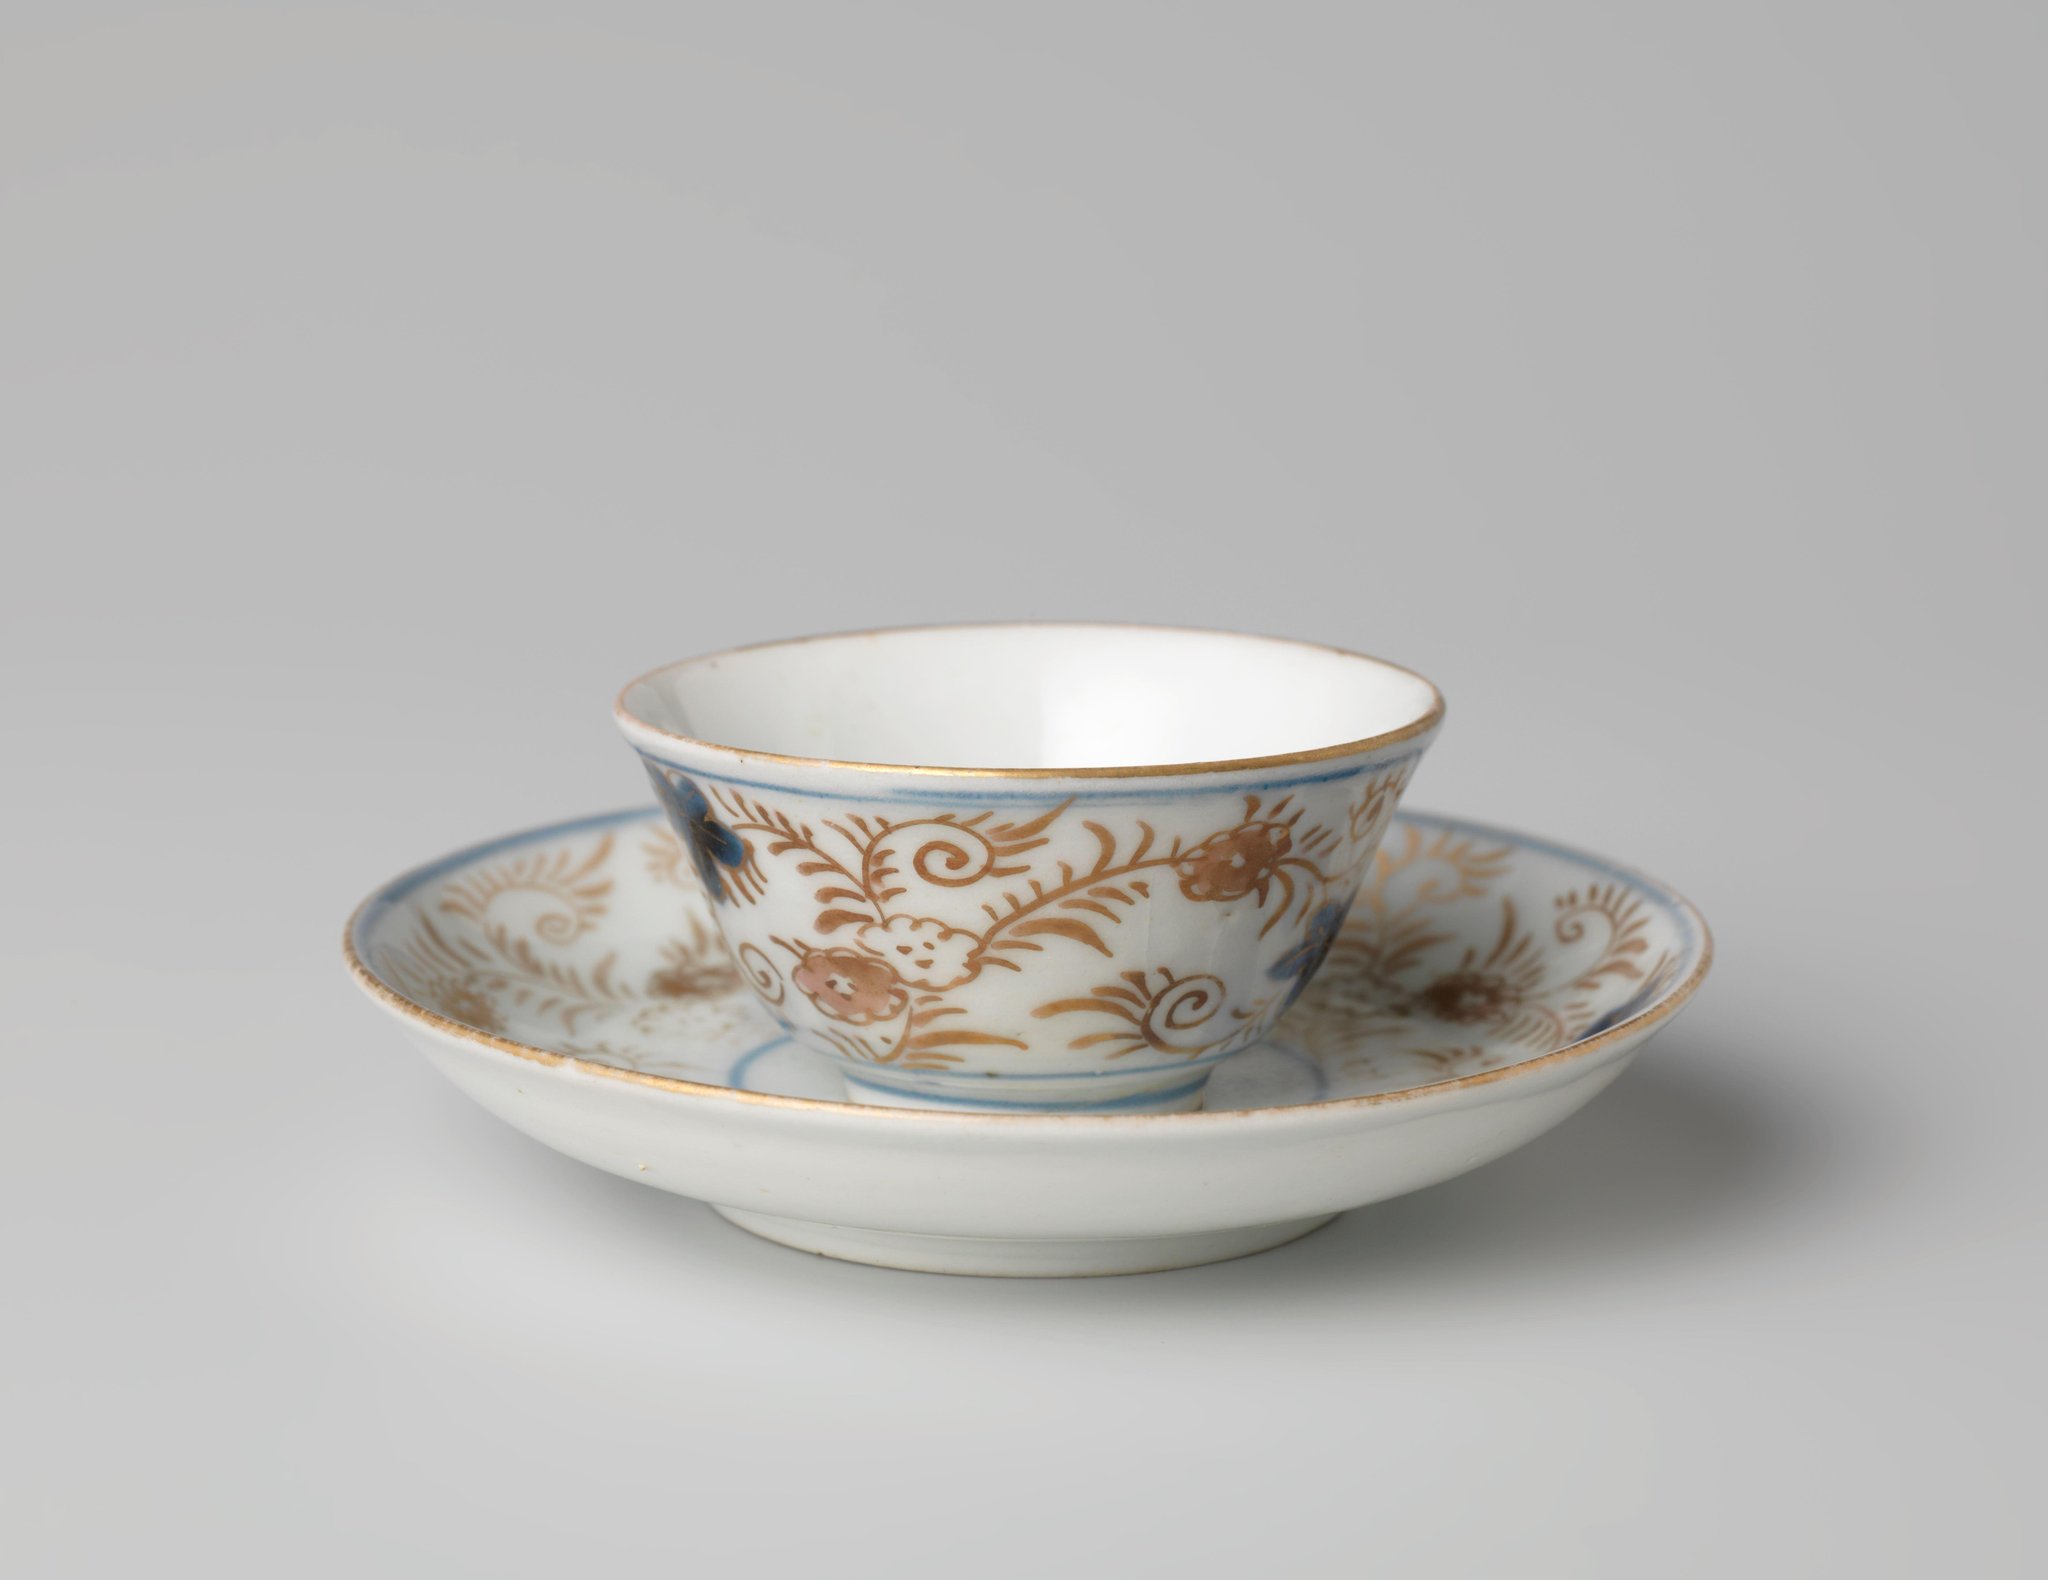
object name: kop en schotel, kop en schotel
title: Bell-shaped cup and saucer with a flower basket and floral scrolls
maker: Anonymous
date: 1775-1799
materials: cobalt, glaze, gold, paint, porcelain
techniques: firing, gilding, turning, vitrification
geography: japan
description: Klokvormige kop en schotel van porselein, beschilderd in onderglazuur blauw en op het glazuur goud. Op het plat in een medaillon een bloempot; de wand is verdeeld in drie waaiervormige vakken gescheiden door een brede streep met een bloem. In de vakken bloemranken. De kop met dezelfde decoratie. Een barst in de kop. Imari.